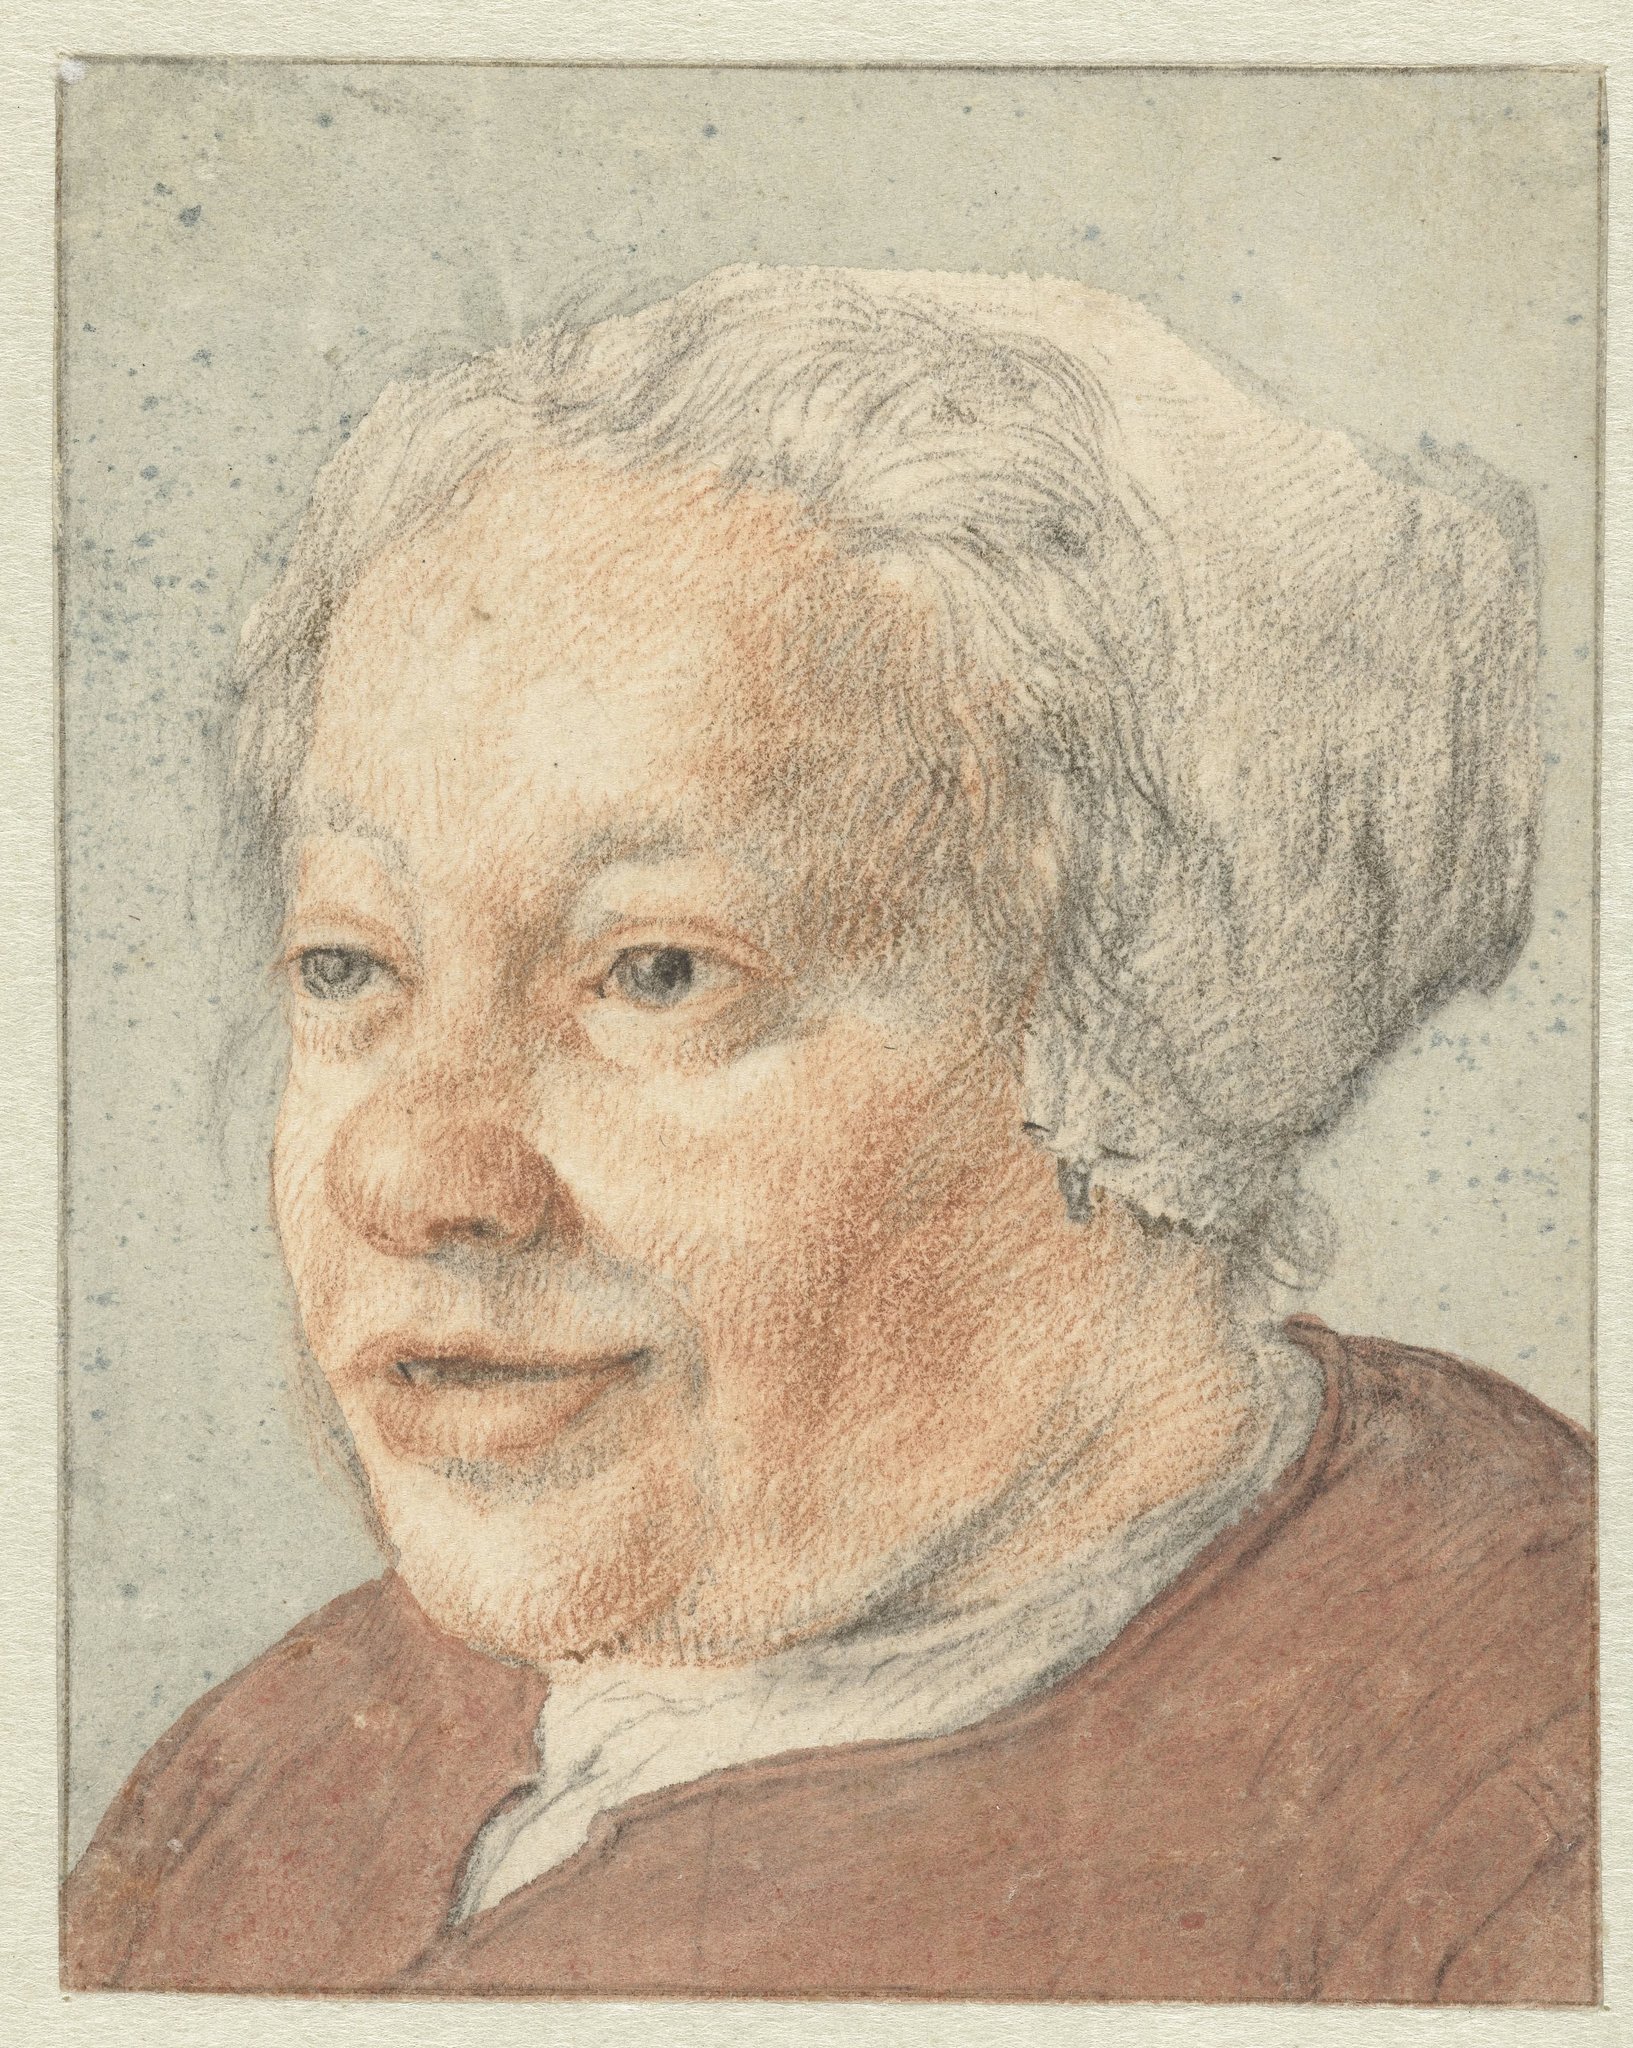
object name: drawing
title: Hoofd van een vrouw, driekwart naar links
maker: cornelis dusart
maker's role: draughtsman, painter, print maker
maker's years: 1660-1704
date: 1670-1704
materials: chalk, paper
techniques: brush